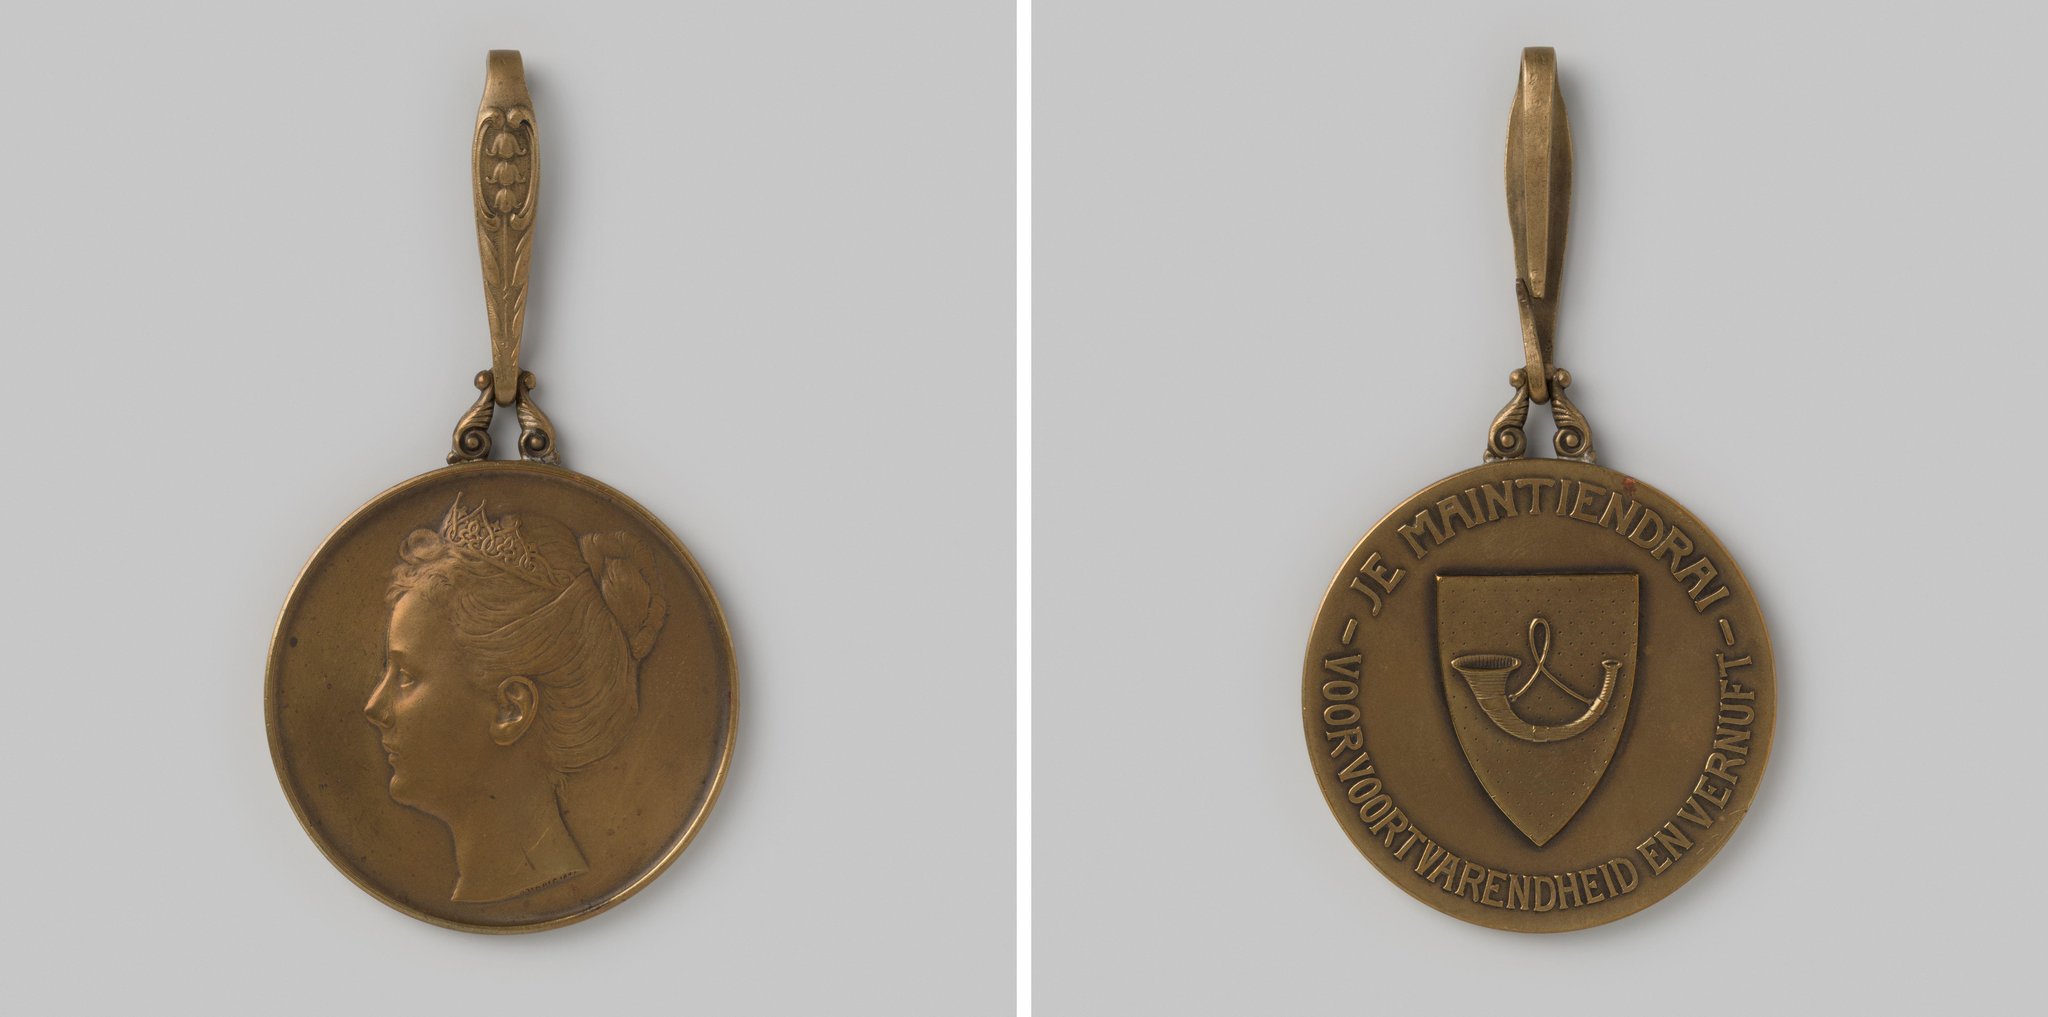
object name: history medal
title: Beloningspenning voor Voortvarendheid en Vernuft 1917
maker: pier pander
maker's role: designer, draughtsman, sculptor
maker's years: 1864-1919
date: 1917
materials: bronze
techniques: striking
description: Bronzen penning met versierd oog en draaggesp met bloemmotieven, op de voorzijde het portret van Koningin Wilhelmina naar links, op de keerzijde een wapenschild met posthoorn met omschrift.